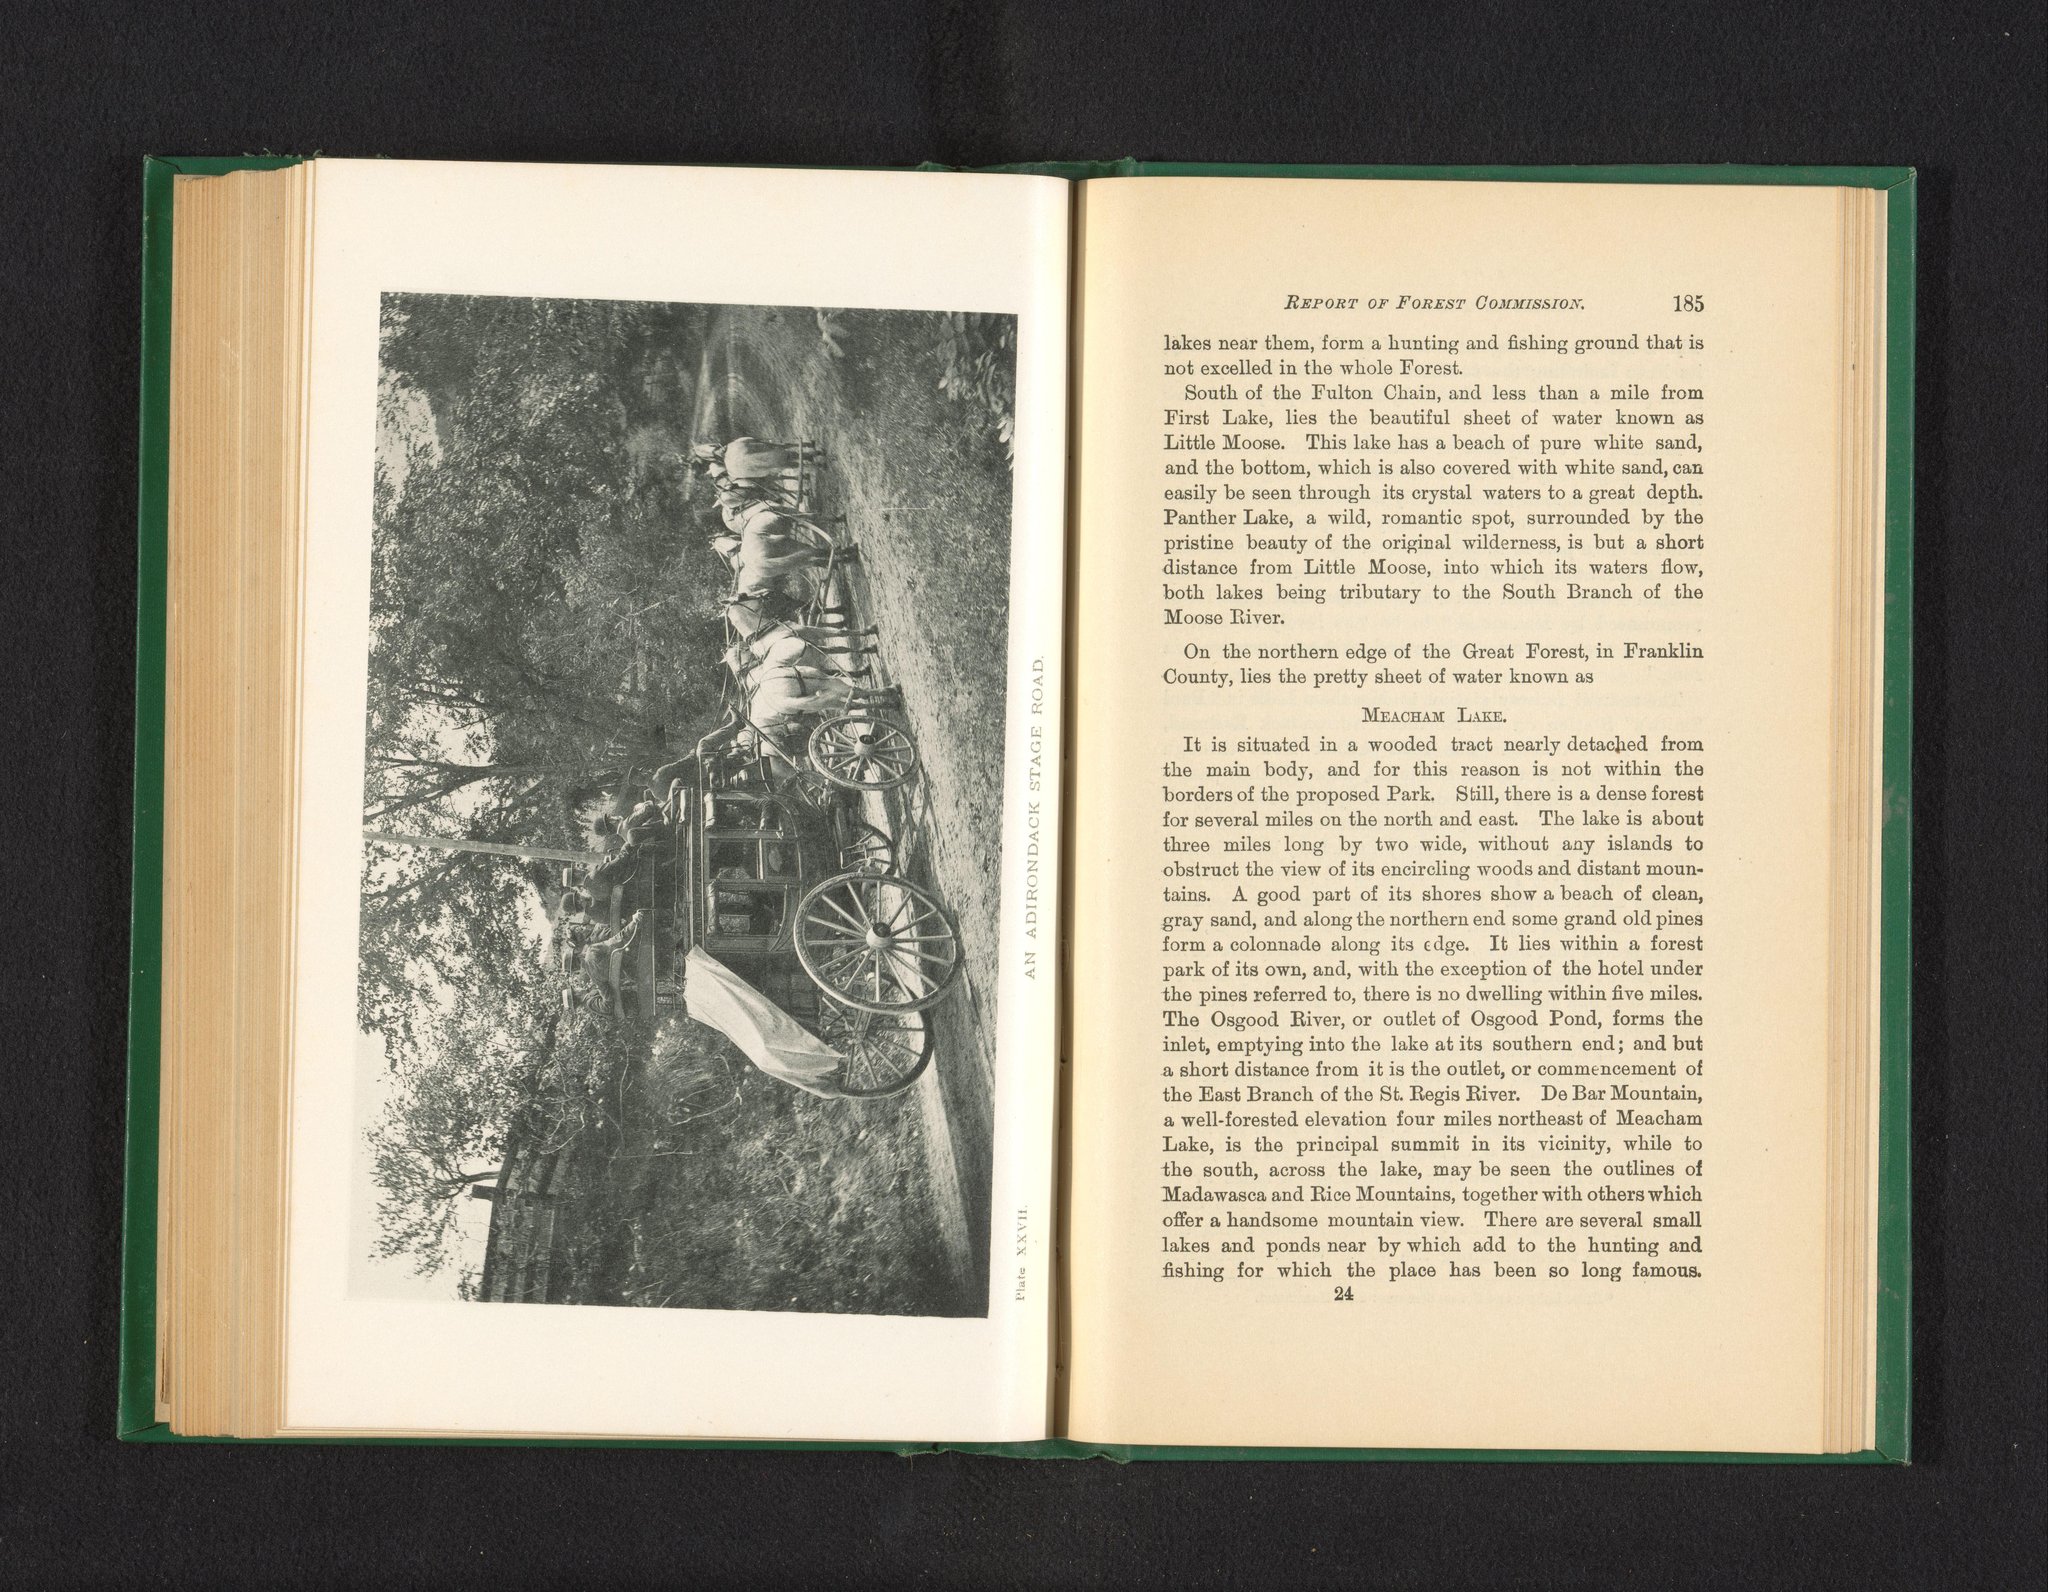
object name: photomechanical print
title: An Adirondack stage road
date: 1891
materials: paper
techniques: photograph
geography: adirondack mountains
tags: four-wheeled, animal-drawn vehicle, e.g.: cab, carriage, coach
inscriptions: number: ‘Plate XXVII.’